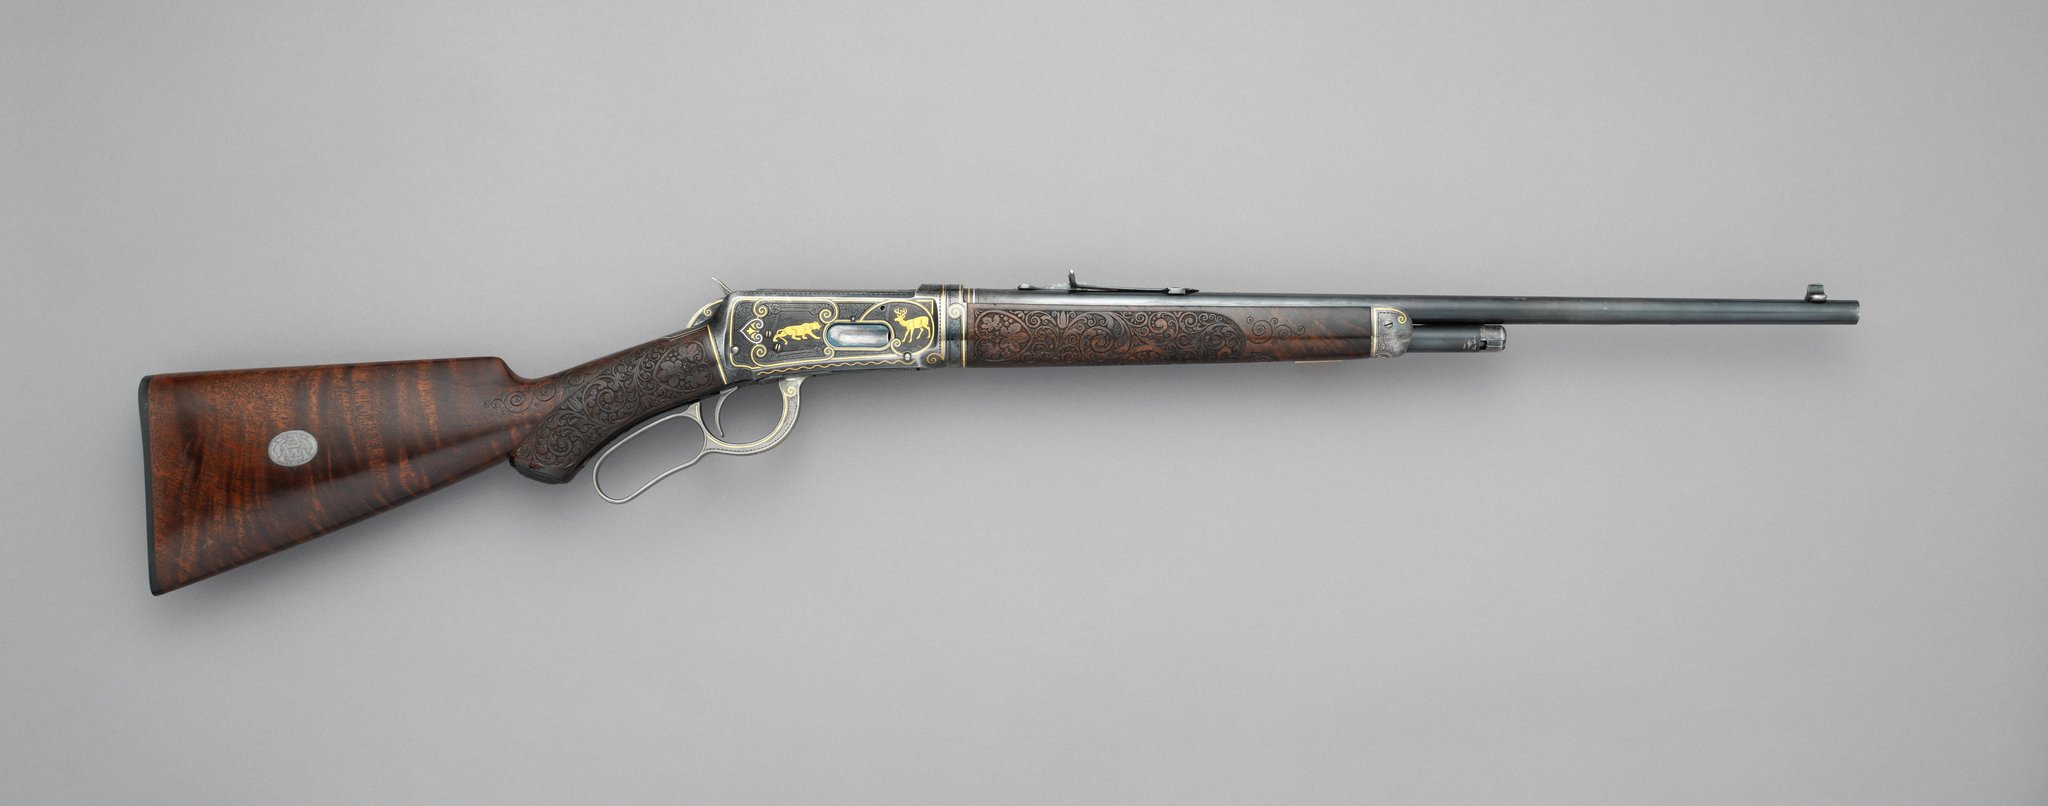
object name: rifle with box of sight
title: Winchester Model 1894 Takedown Rifle (serial no. 311946) with Box of Sights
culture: american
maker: winchester repeating arms company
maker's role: manufacturer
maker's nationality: american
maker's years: 1866-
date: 1906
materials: gold, leather, platinum, silver, steel, textile, wood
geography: united states